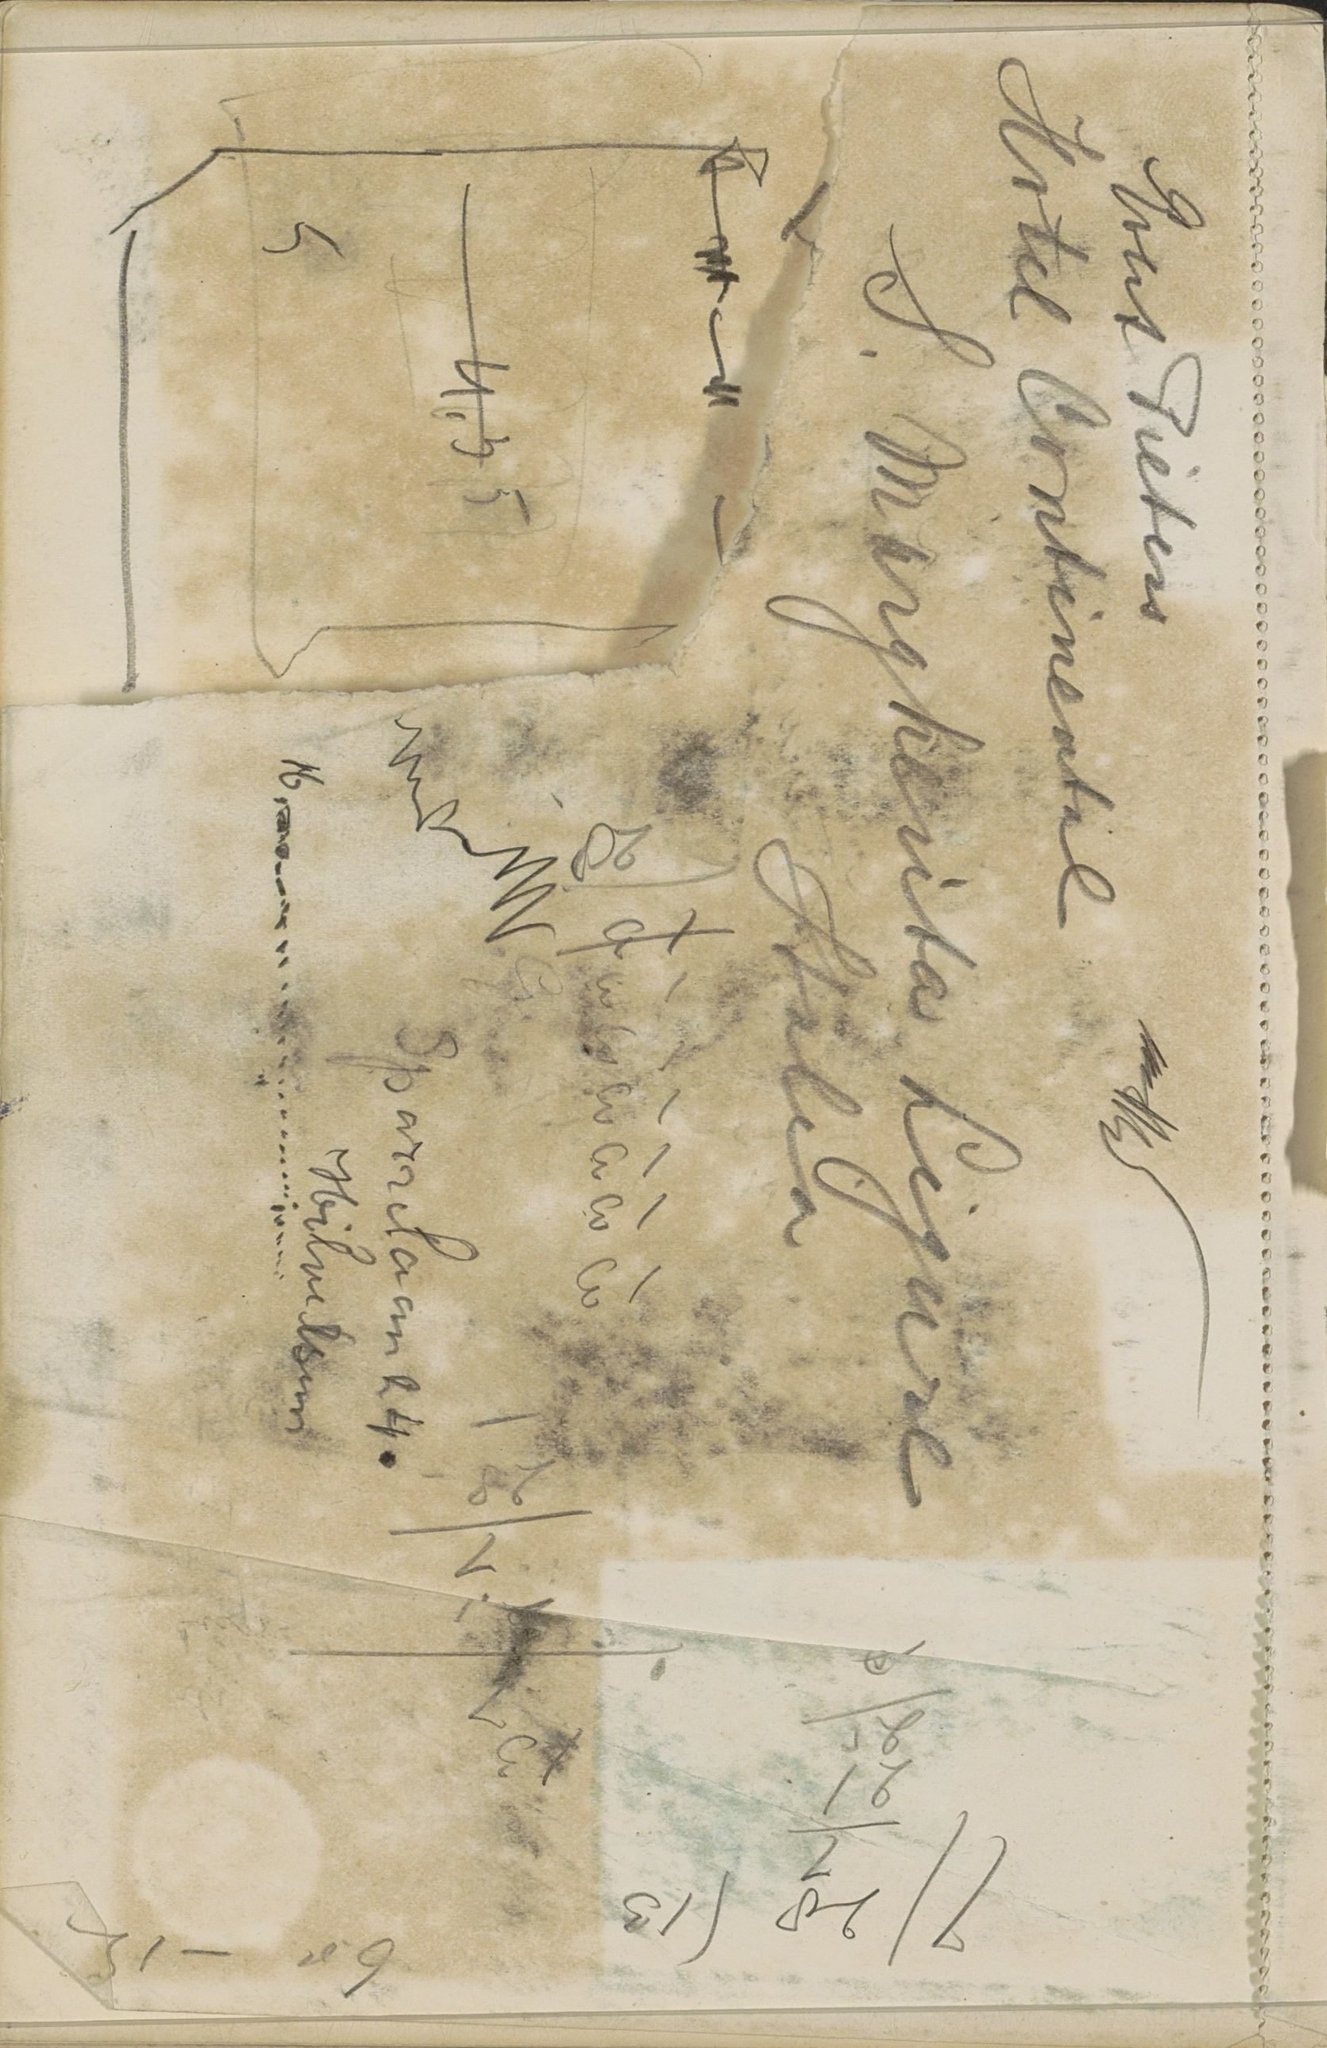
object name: sketchbook leaf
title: Adressen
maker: cornelis vreedenburgh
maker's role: draughtsman, print maker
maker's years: 1880-1946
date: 1890-1946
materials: paper, pencil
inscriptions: annotation: ‘[...]kt Pieters/ Hotel Continental/ S. Margherita Ligure/ Italia/ Sparrelaan 24./ Hilversum’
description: Blad 59 verso uit een schetsboek met 59 bladen.